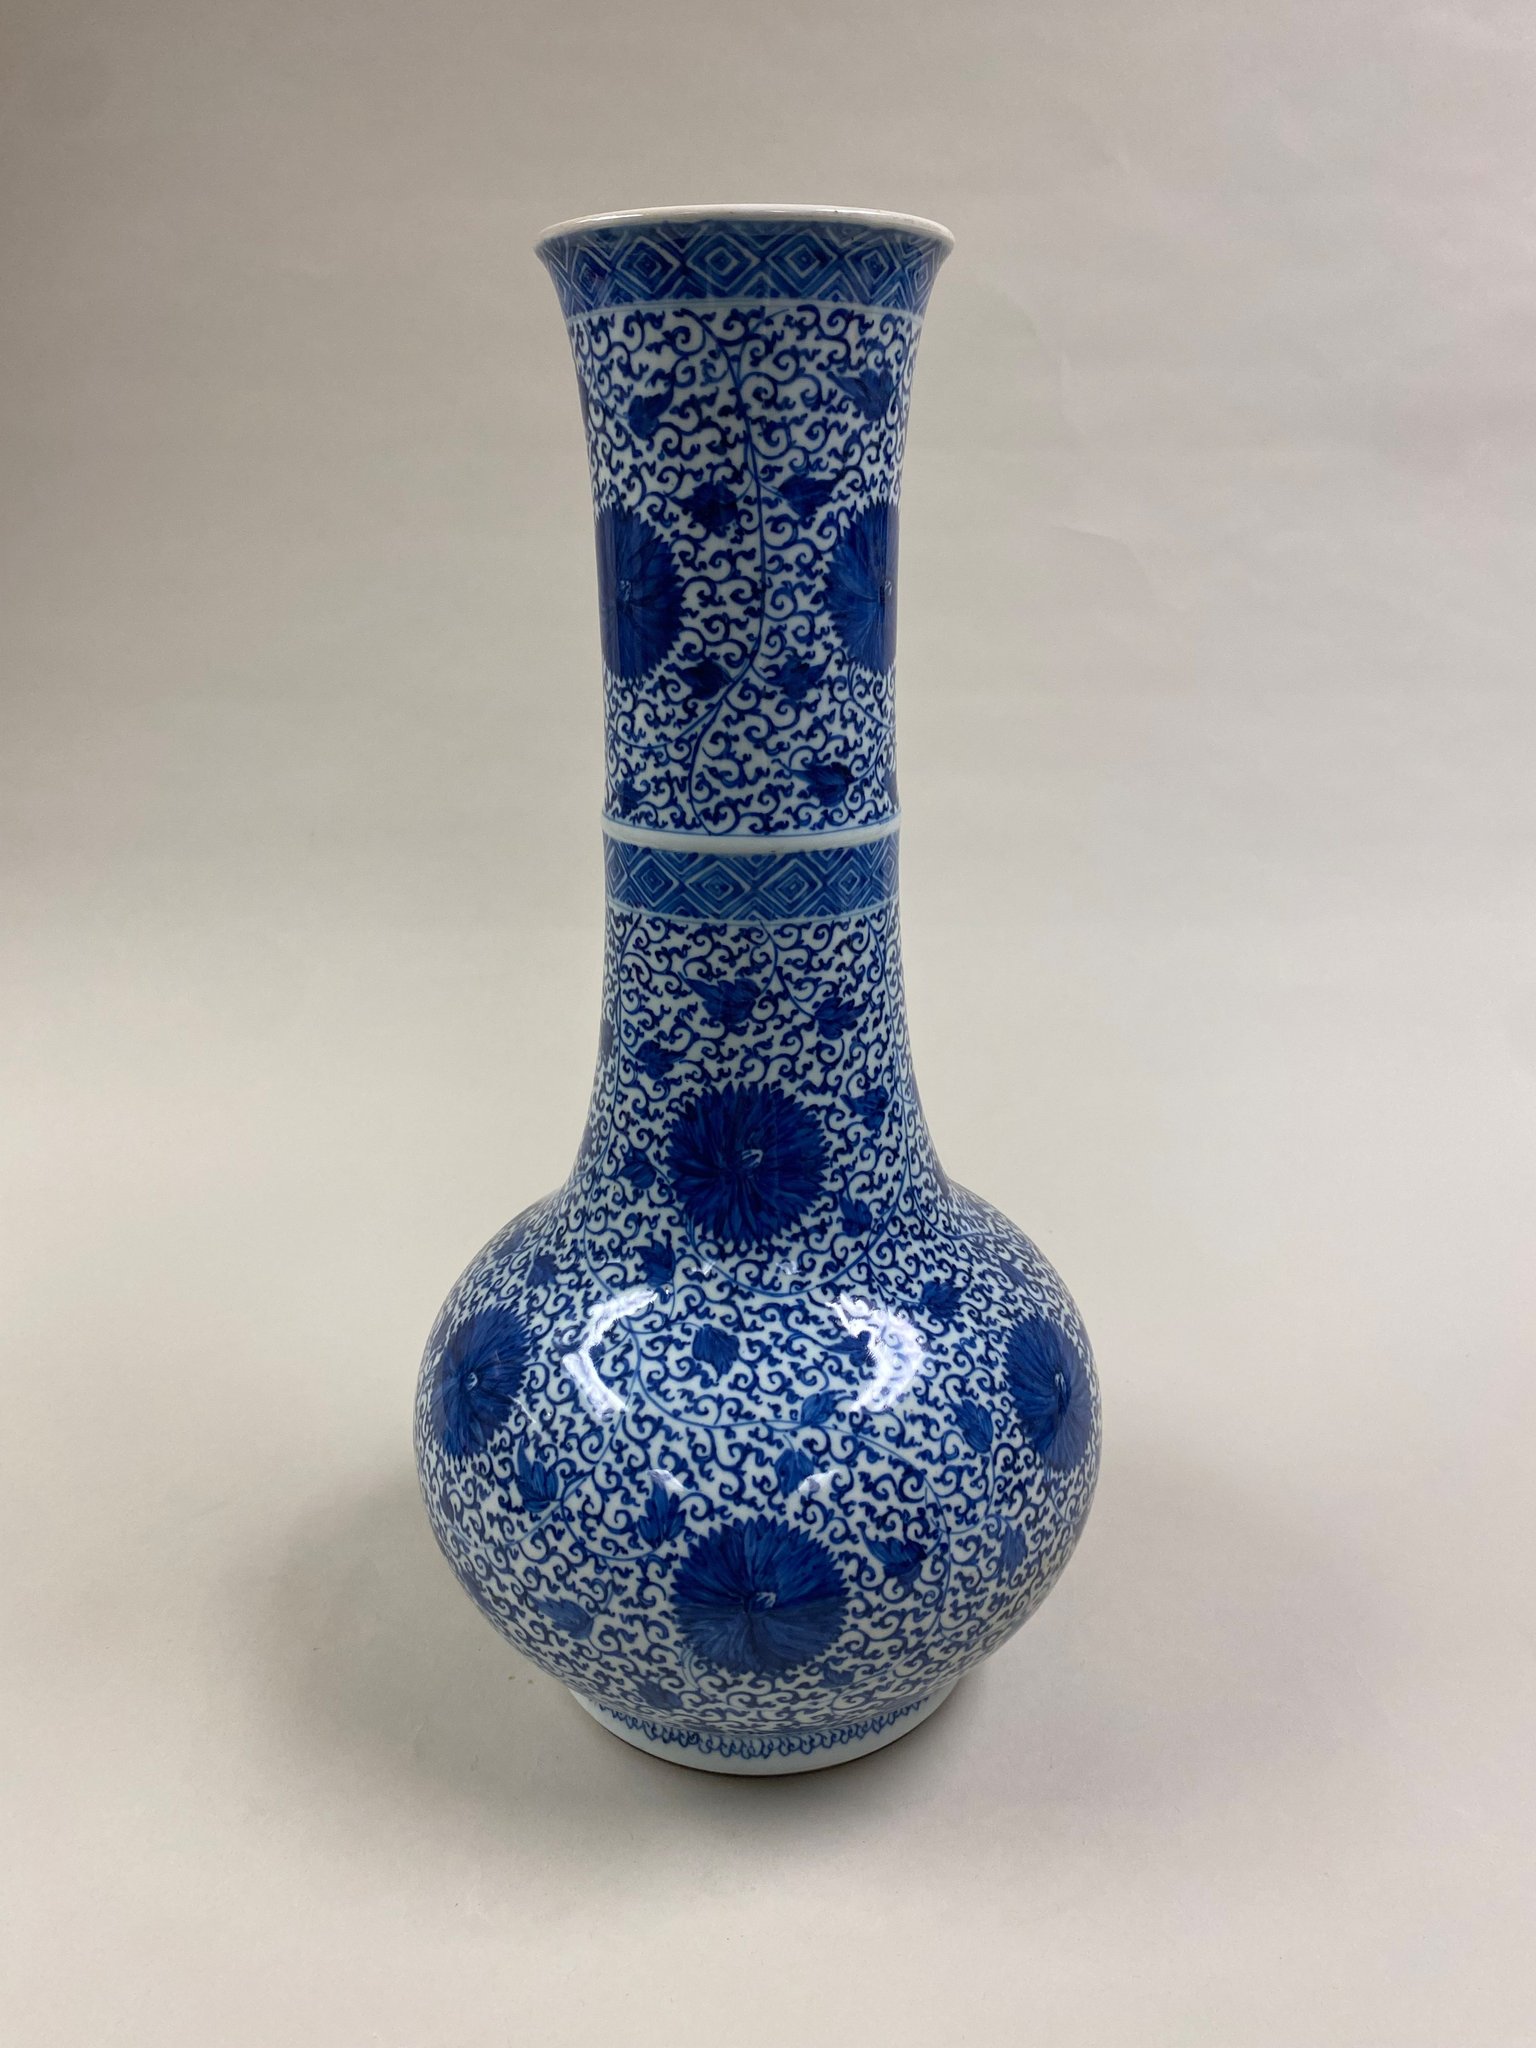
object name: vase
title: Bottle vase with floral scrolls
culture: chinese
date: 1667-1733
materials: cobalt, porcelain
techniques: painting, underglaze